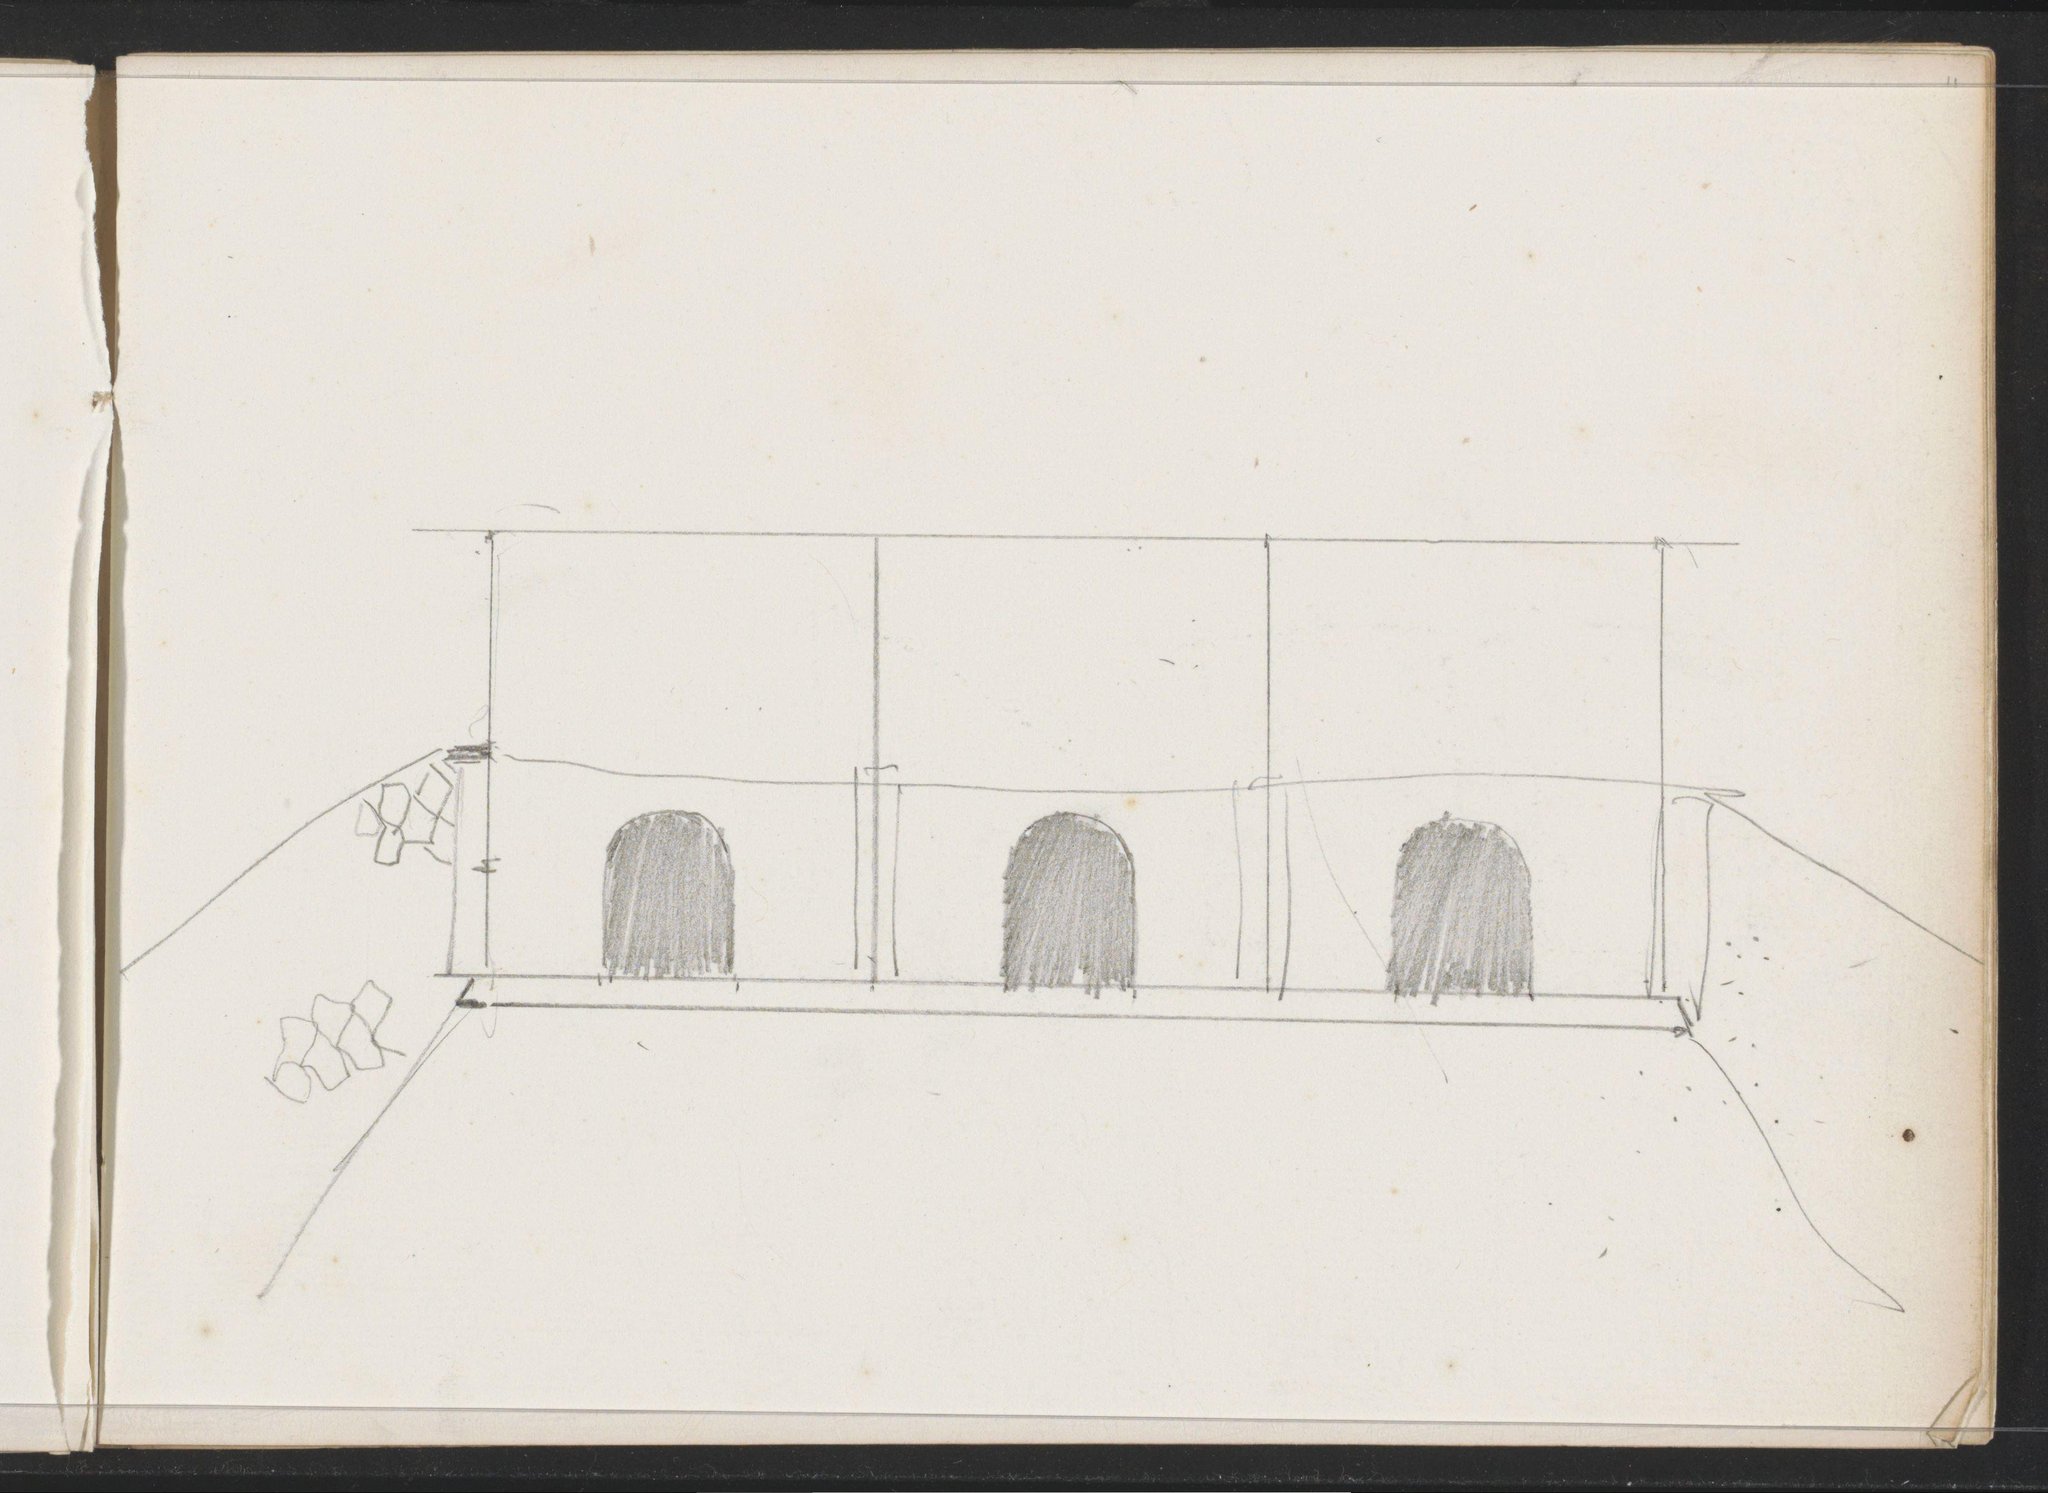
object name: sketchbook leaf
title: Gebouw met drie rondbogen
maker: willem witsen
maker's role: draughtsman, painter, print maker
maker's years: 1860-1923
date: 1896-1899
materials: paper, pencil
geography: rotterdam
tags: architecture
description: Pagina 11 uit een schetsboek met 13 bladen.